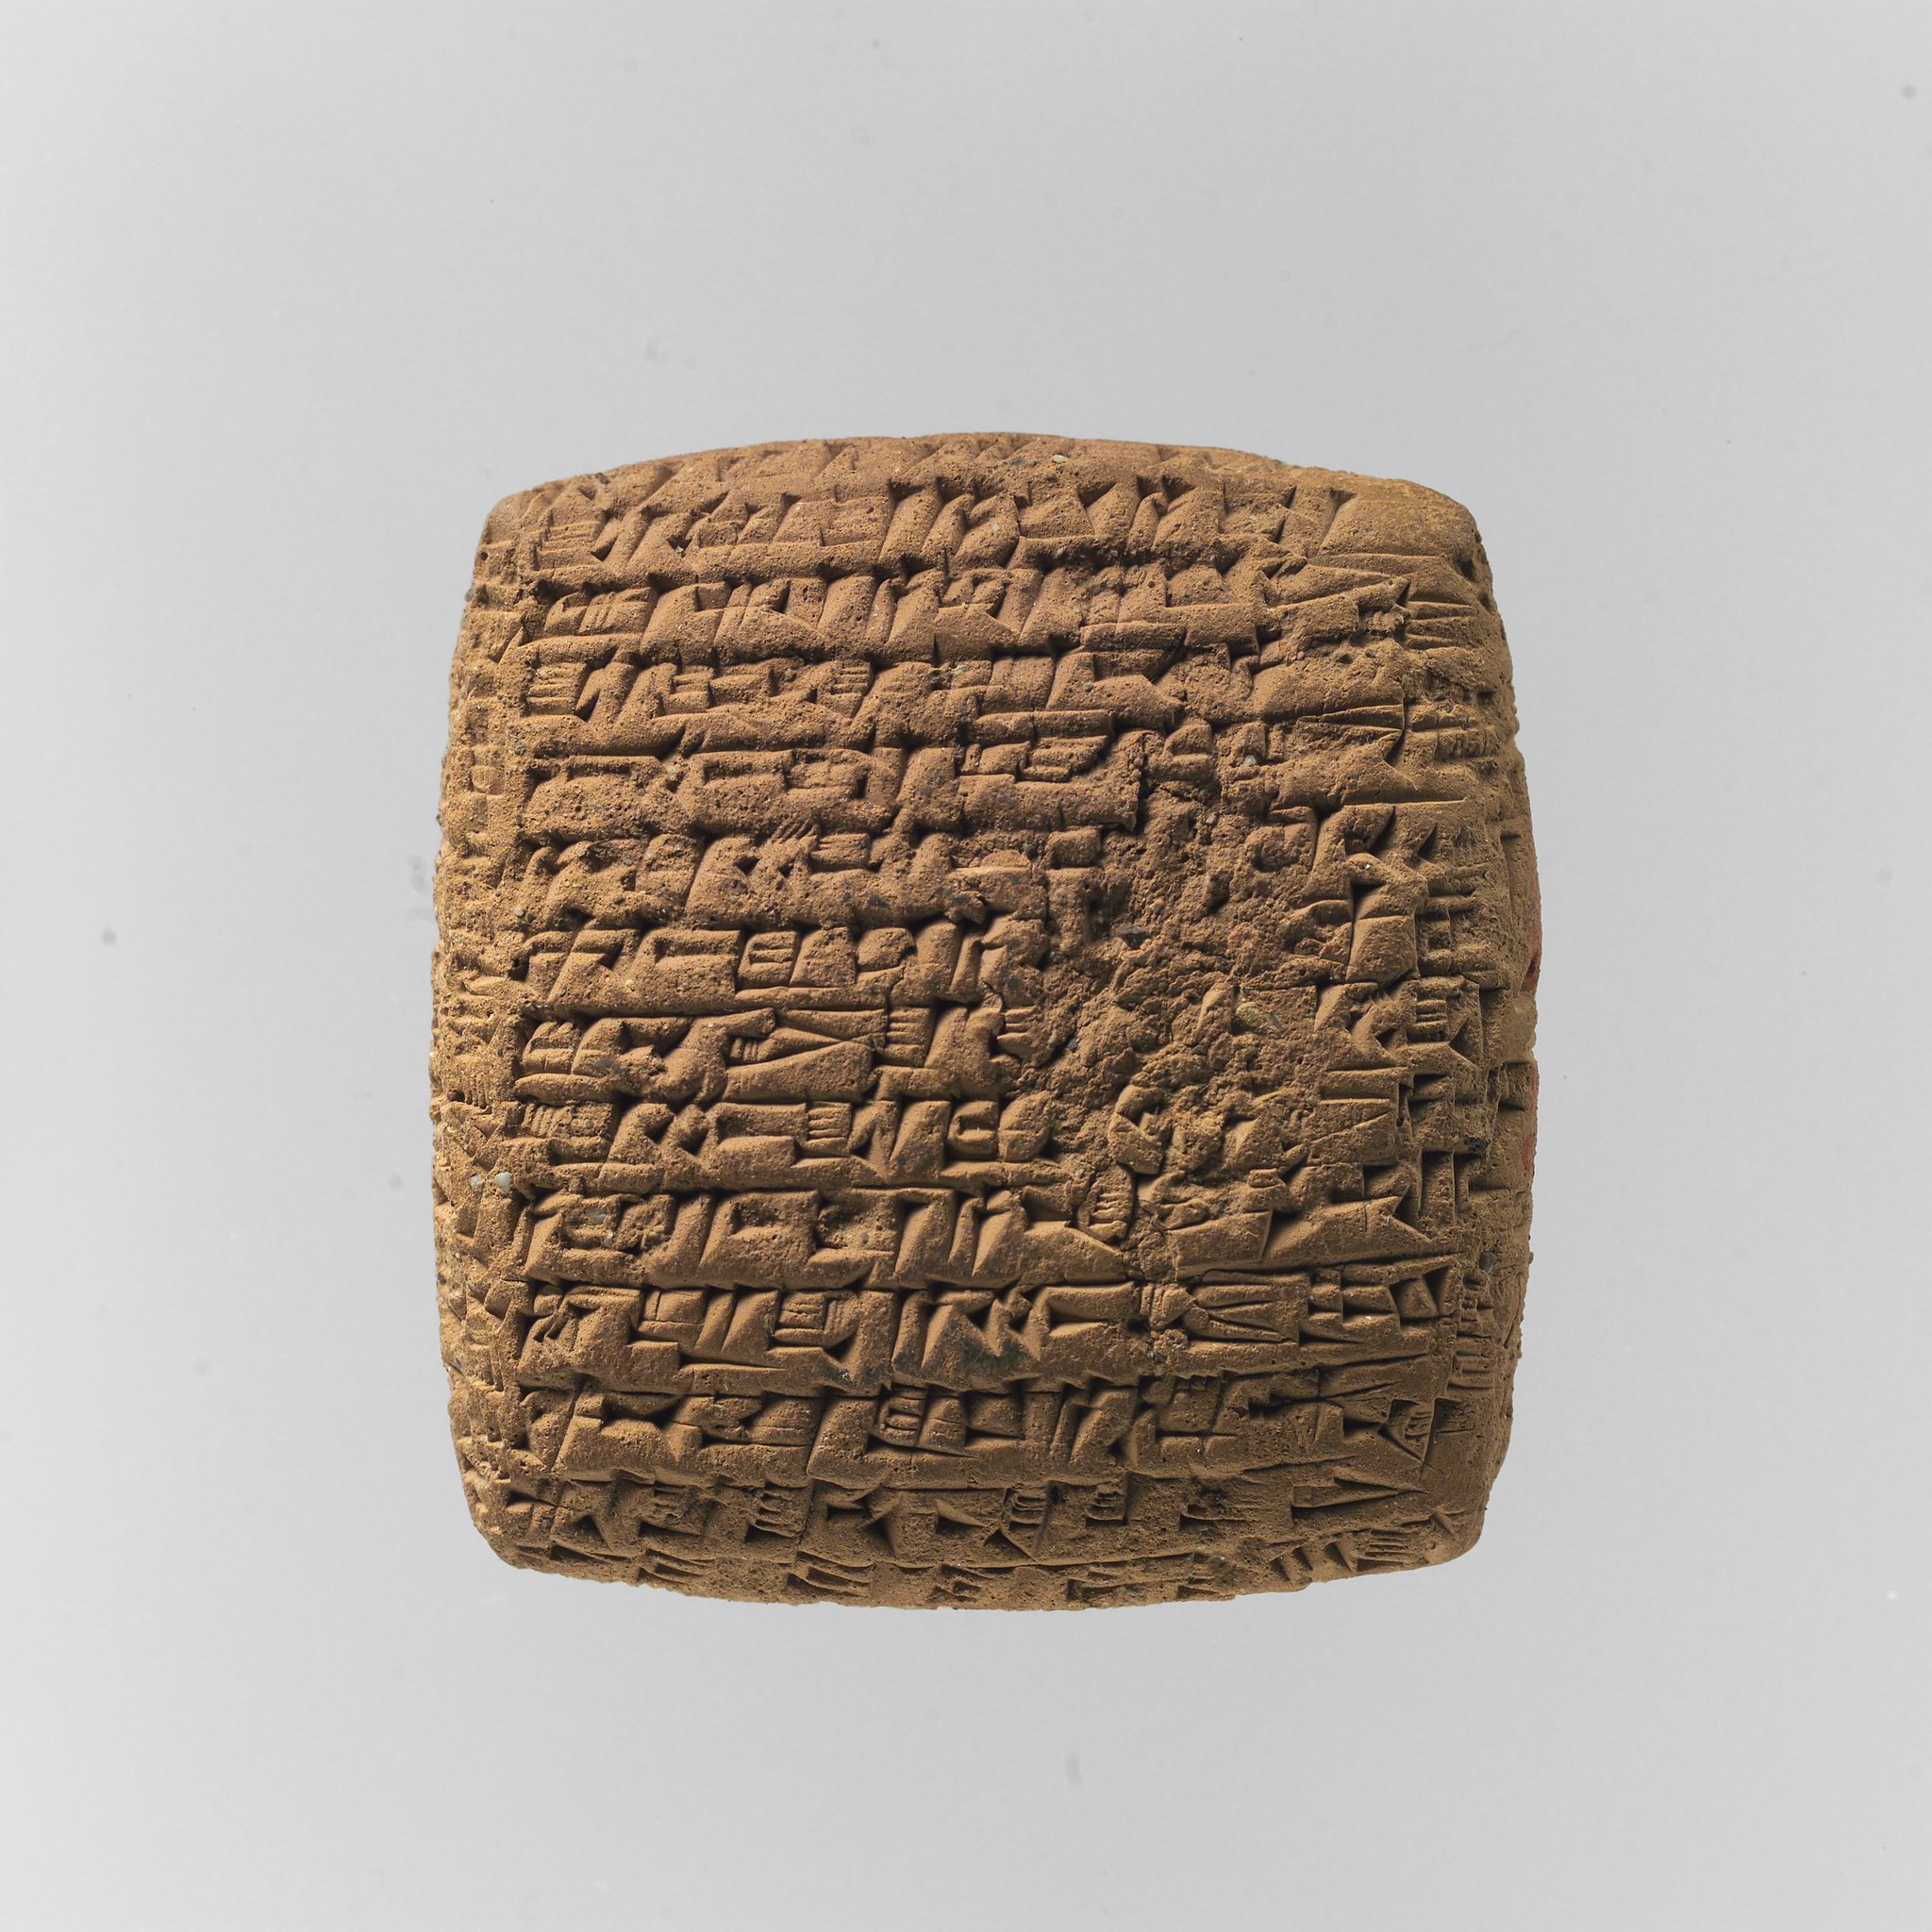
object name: cuneiform tablet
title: Cuneiform tablet: private letter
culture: assyrian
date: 2000-1801 BCE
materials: clay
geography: anatolia